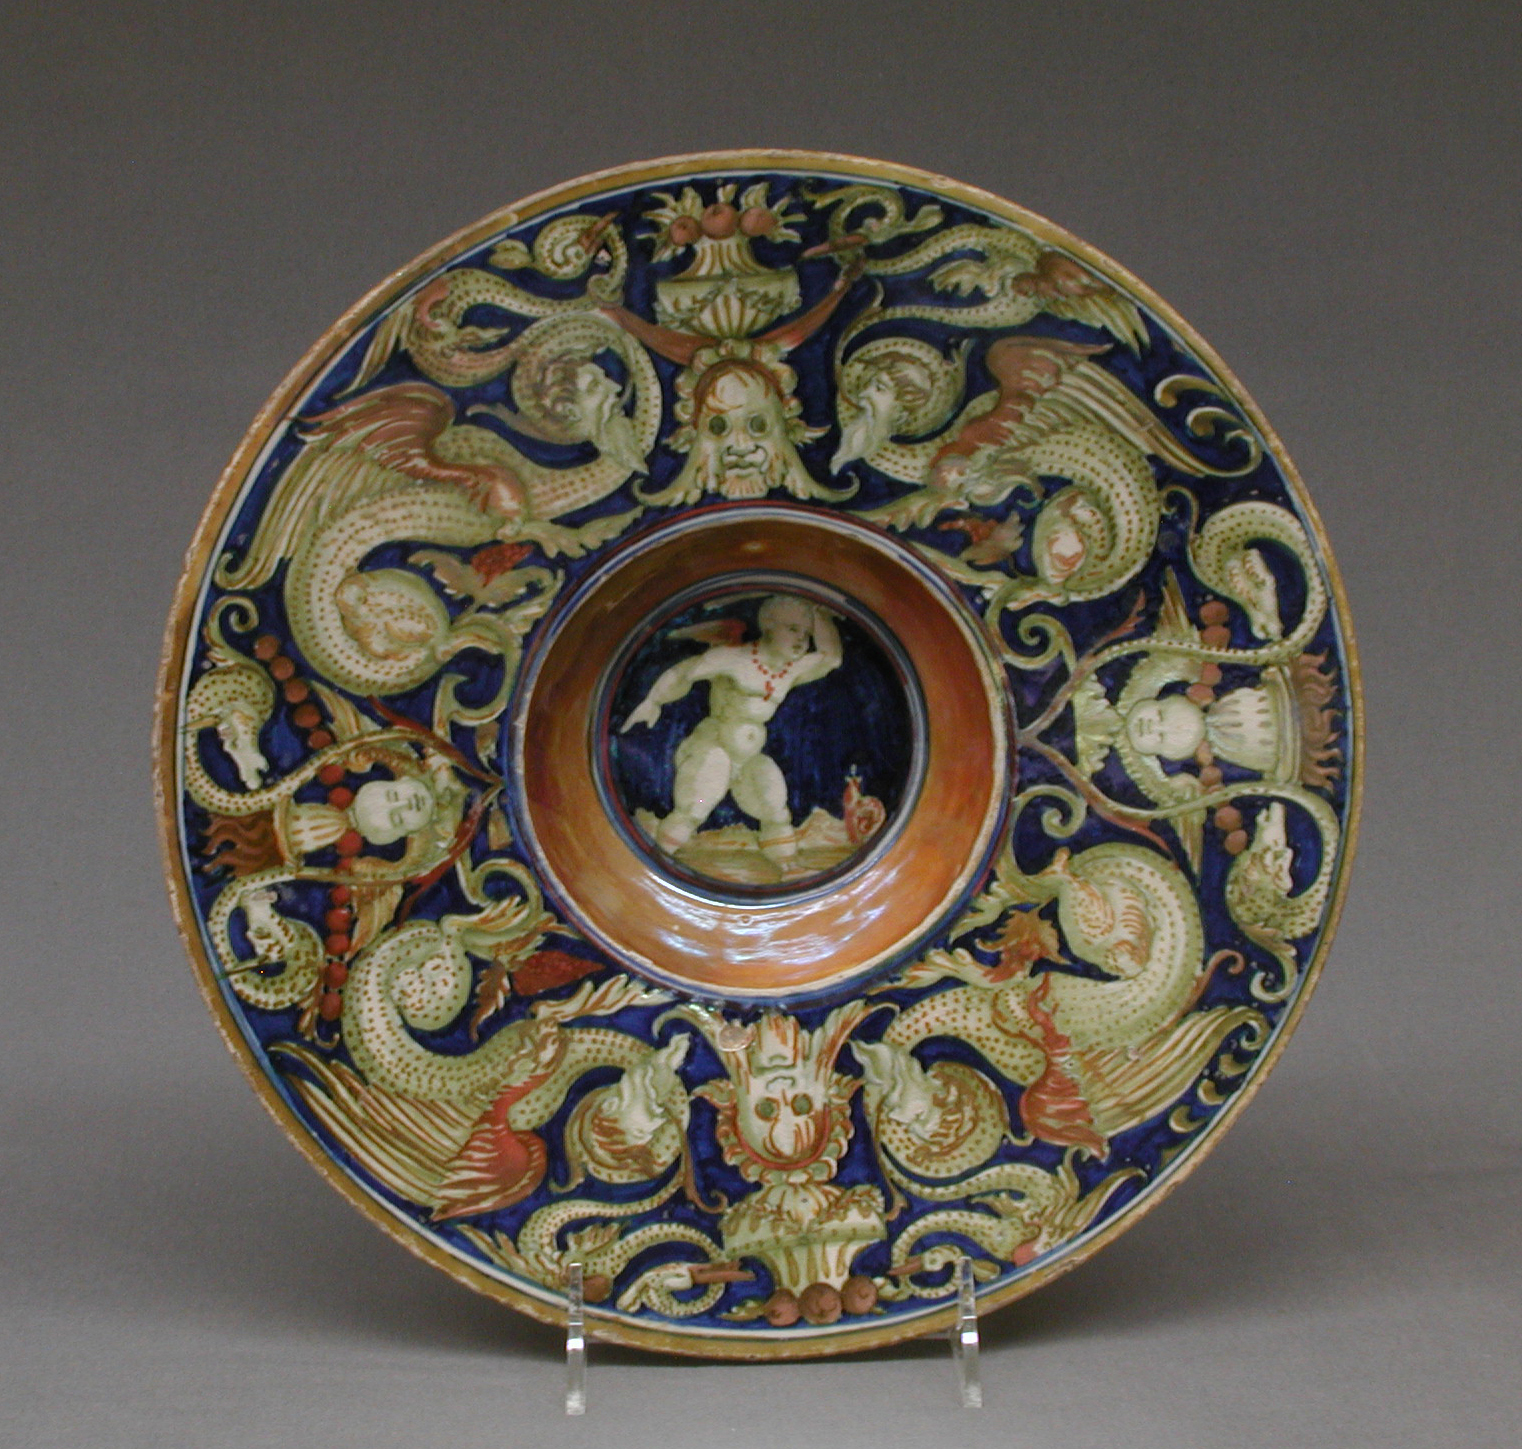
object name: dish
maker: maestro giorgio andreoli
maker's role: artist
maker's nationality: italian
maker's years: 1500-1550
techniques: maiolica, glazing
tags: cupid,mythical creatures